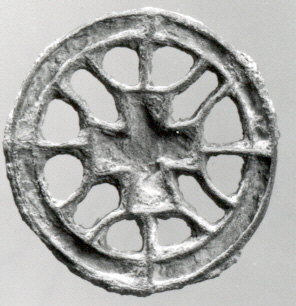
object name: stamp seal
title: Compartmented stamp seal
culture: bactria-margiana archaeological complex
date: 2333-1668 BCE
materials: copper alloy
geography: bactria-margiana